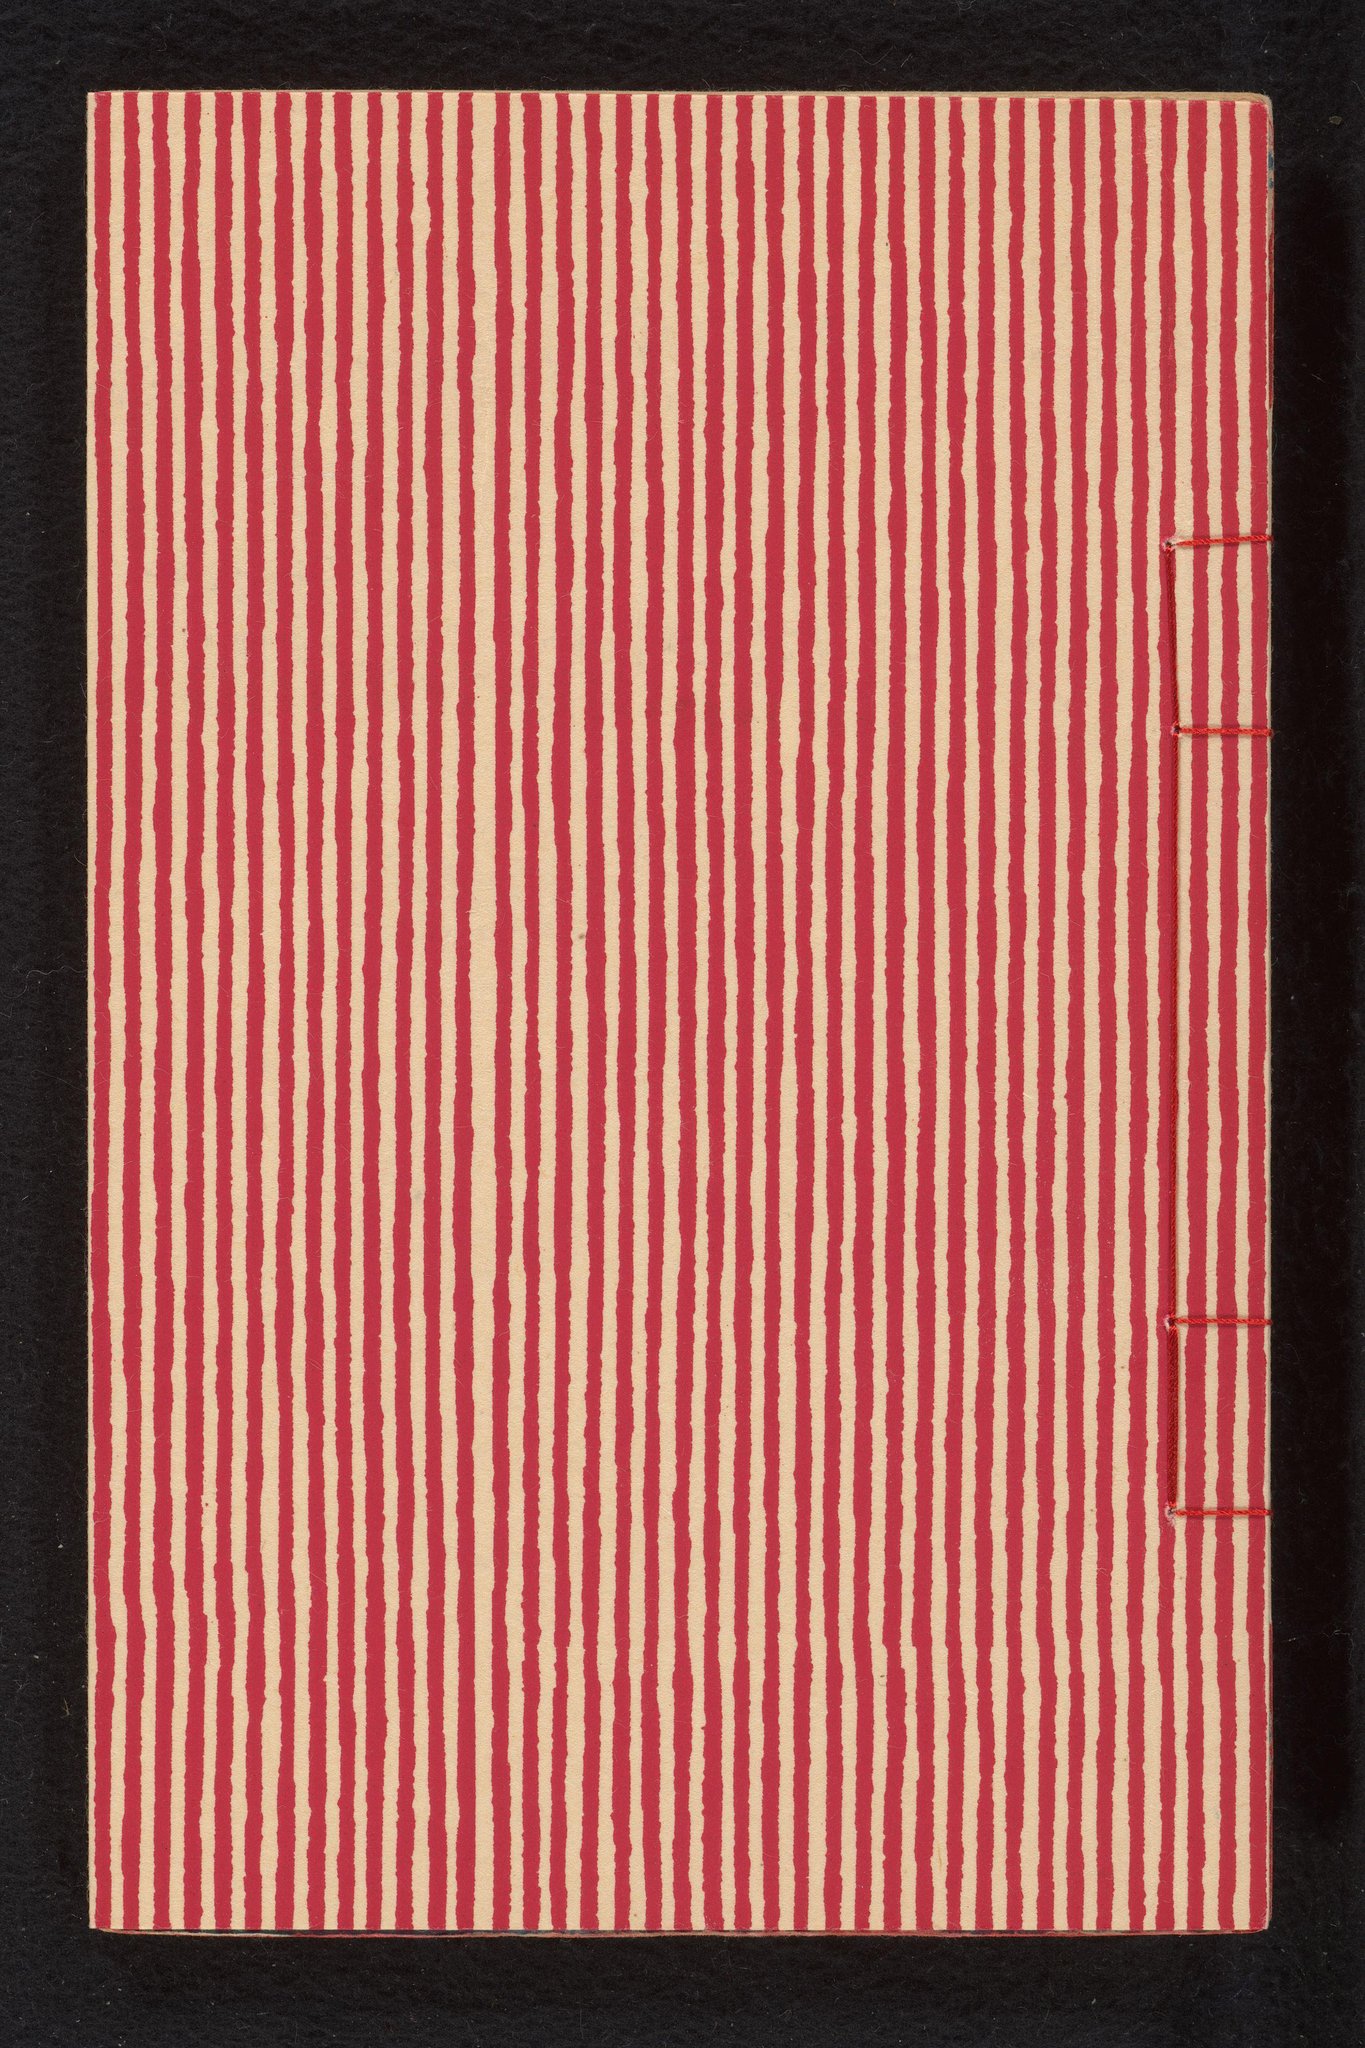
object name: book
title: Bijutsu sekai - 7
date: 1806-1891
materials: paper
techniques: blind stamped, woodcut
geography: japan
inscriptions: collector's mark: Lugt 2228